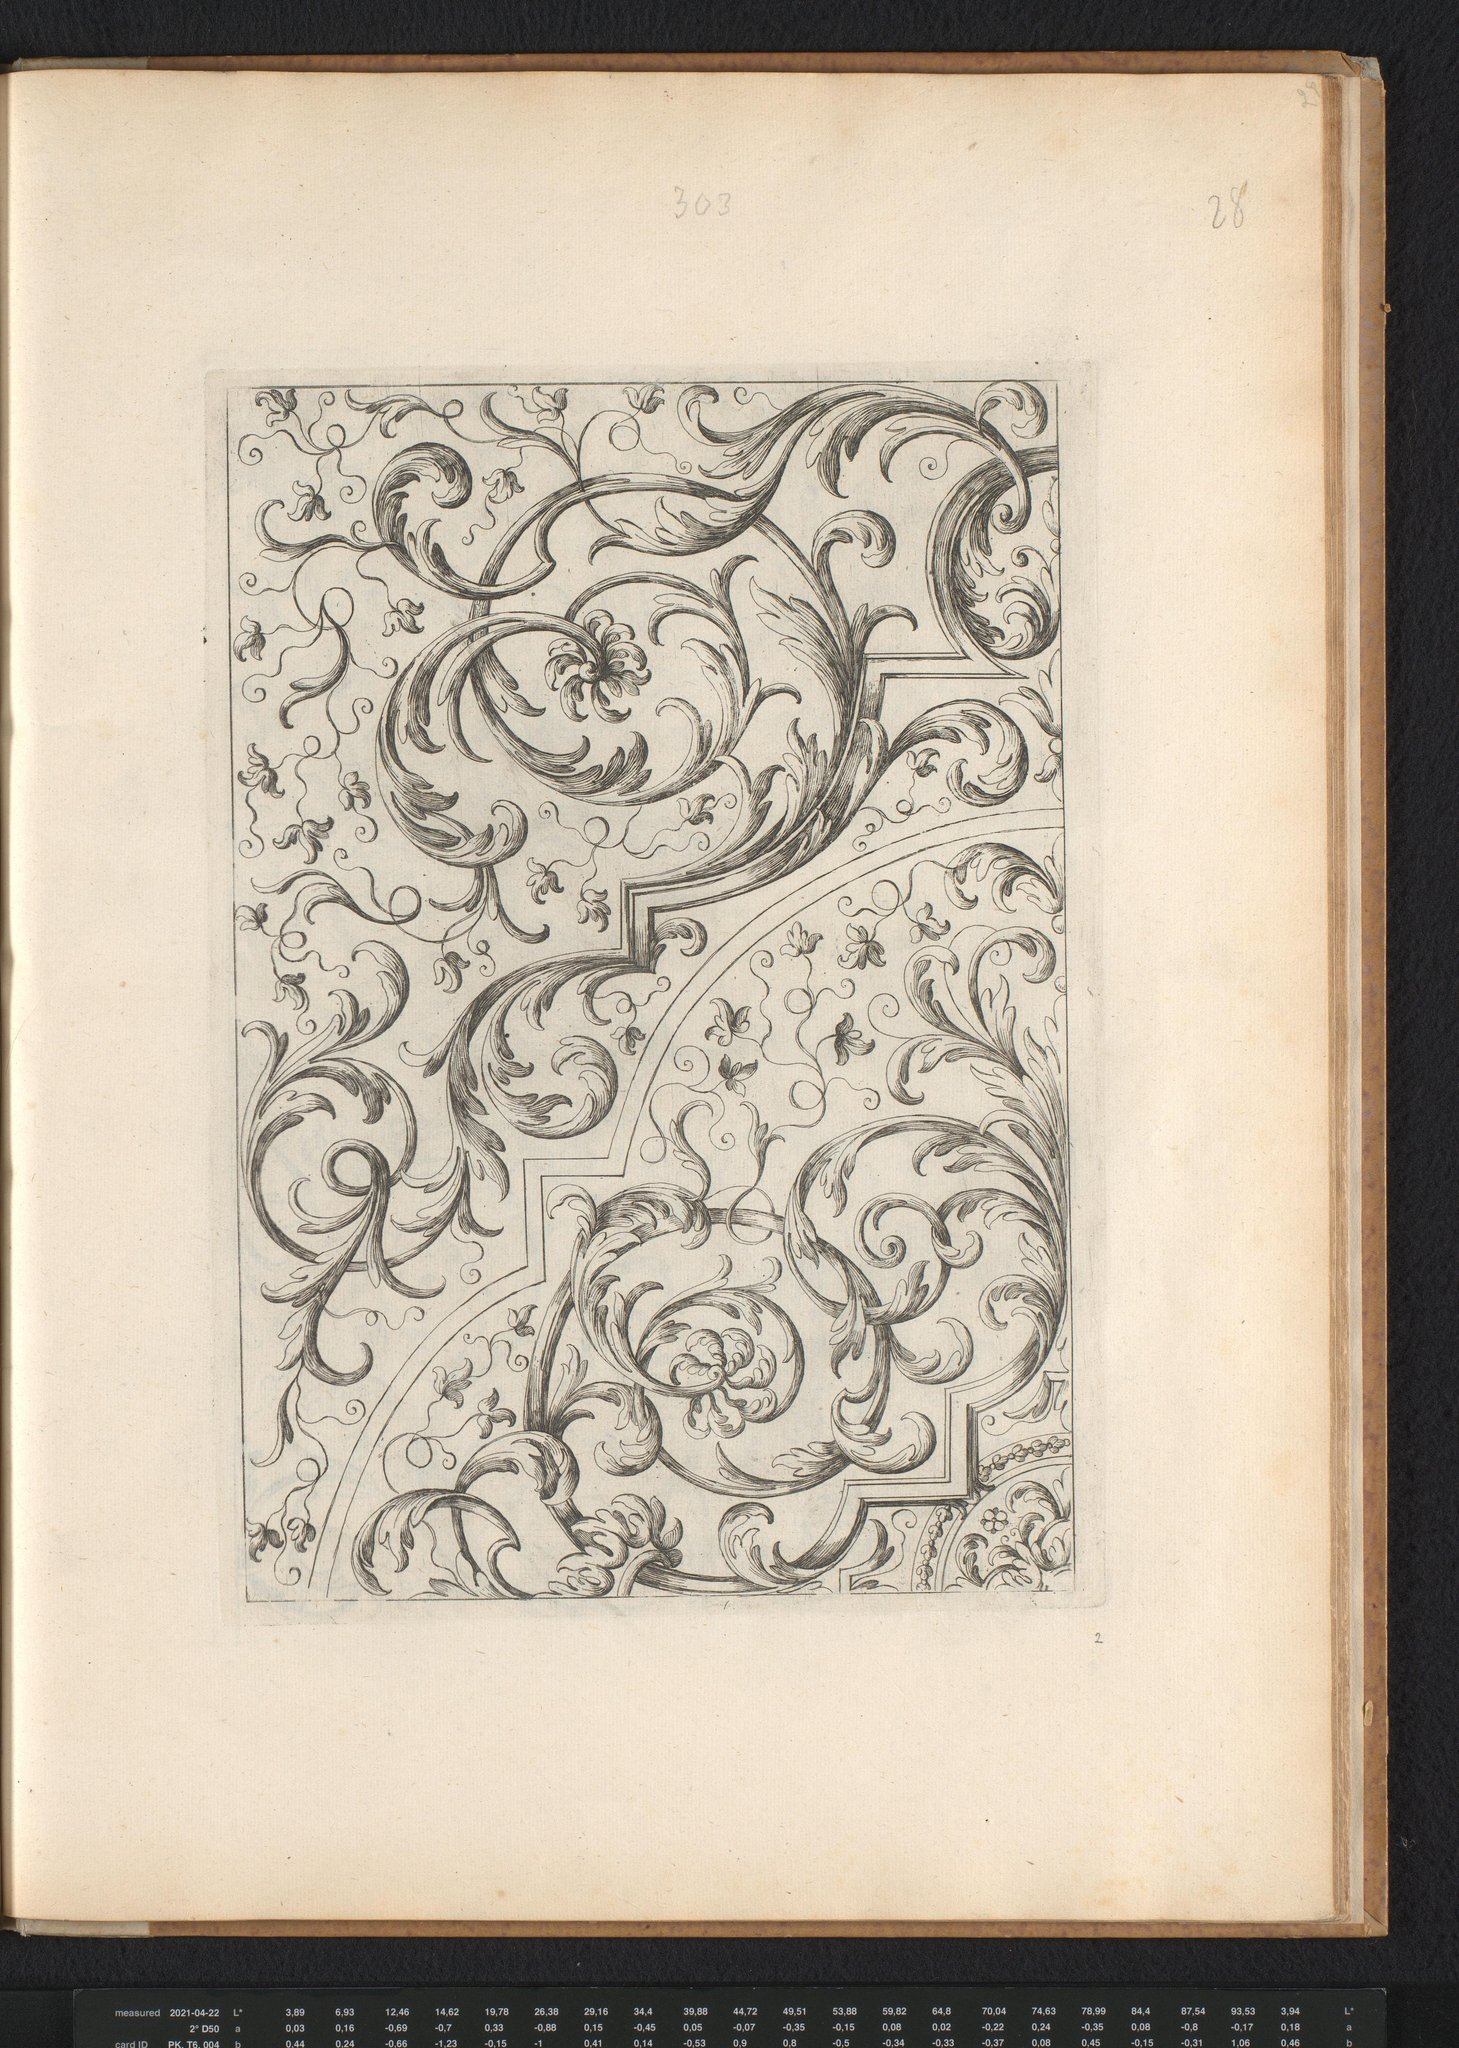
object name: album leaf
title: Ontwerpen voor marqueterie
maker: paul androuet ducerceau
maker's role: painter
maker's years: 1630-1710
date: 1670-1685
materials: paper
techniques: etching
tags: acanthus ~ ornament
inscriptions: collector's mark: Lugt 2228a, collector's mark: Lugt 2760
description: Deze prent maakt deel uit van een album.